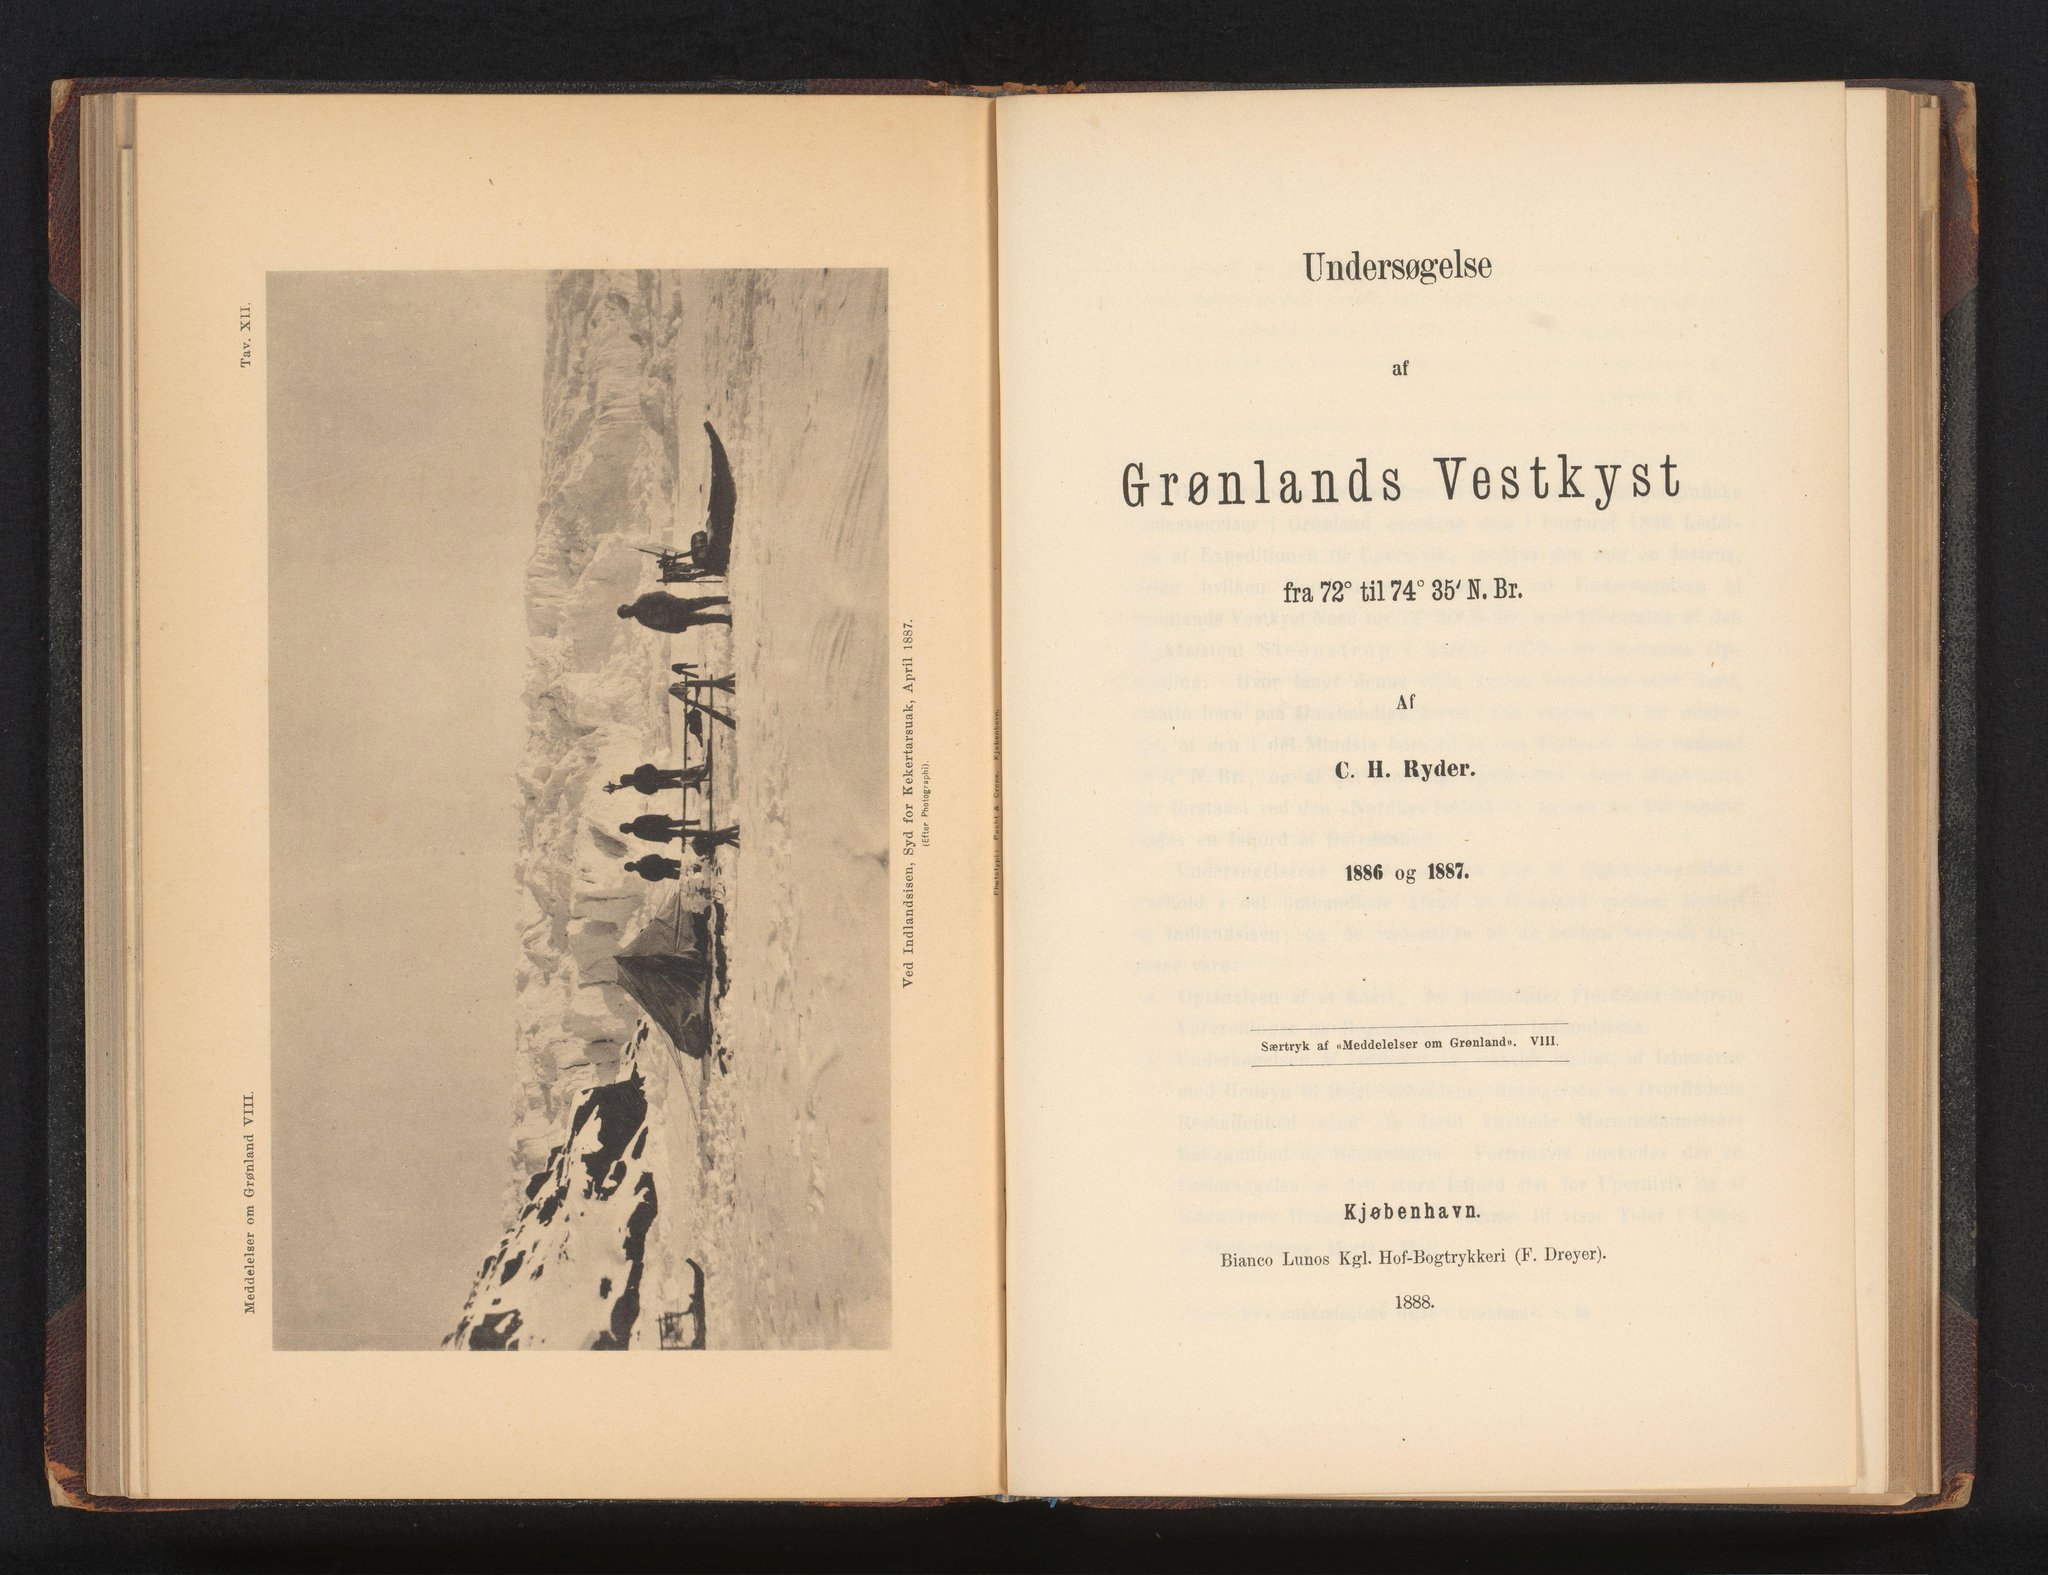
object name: photomechanical print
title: Ved Indiansisen, Syd for Kekertarsuak, April 1887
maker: Anonymous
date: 1804-1887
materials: paper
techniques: photograph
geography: greenland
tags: tent-camp, exploration, expedition, voyage of discovery, greenland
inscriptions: number: ‘Tav. XII.’